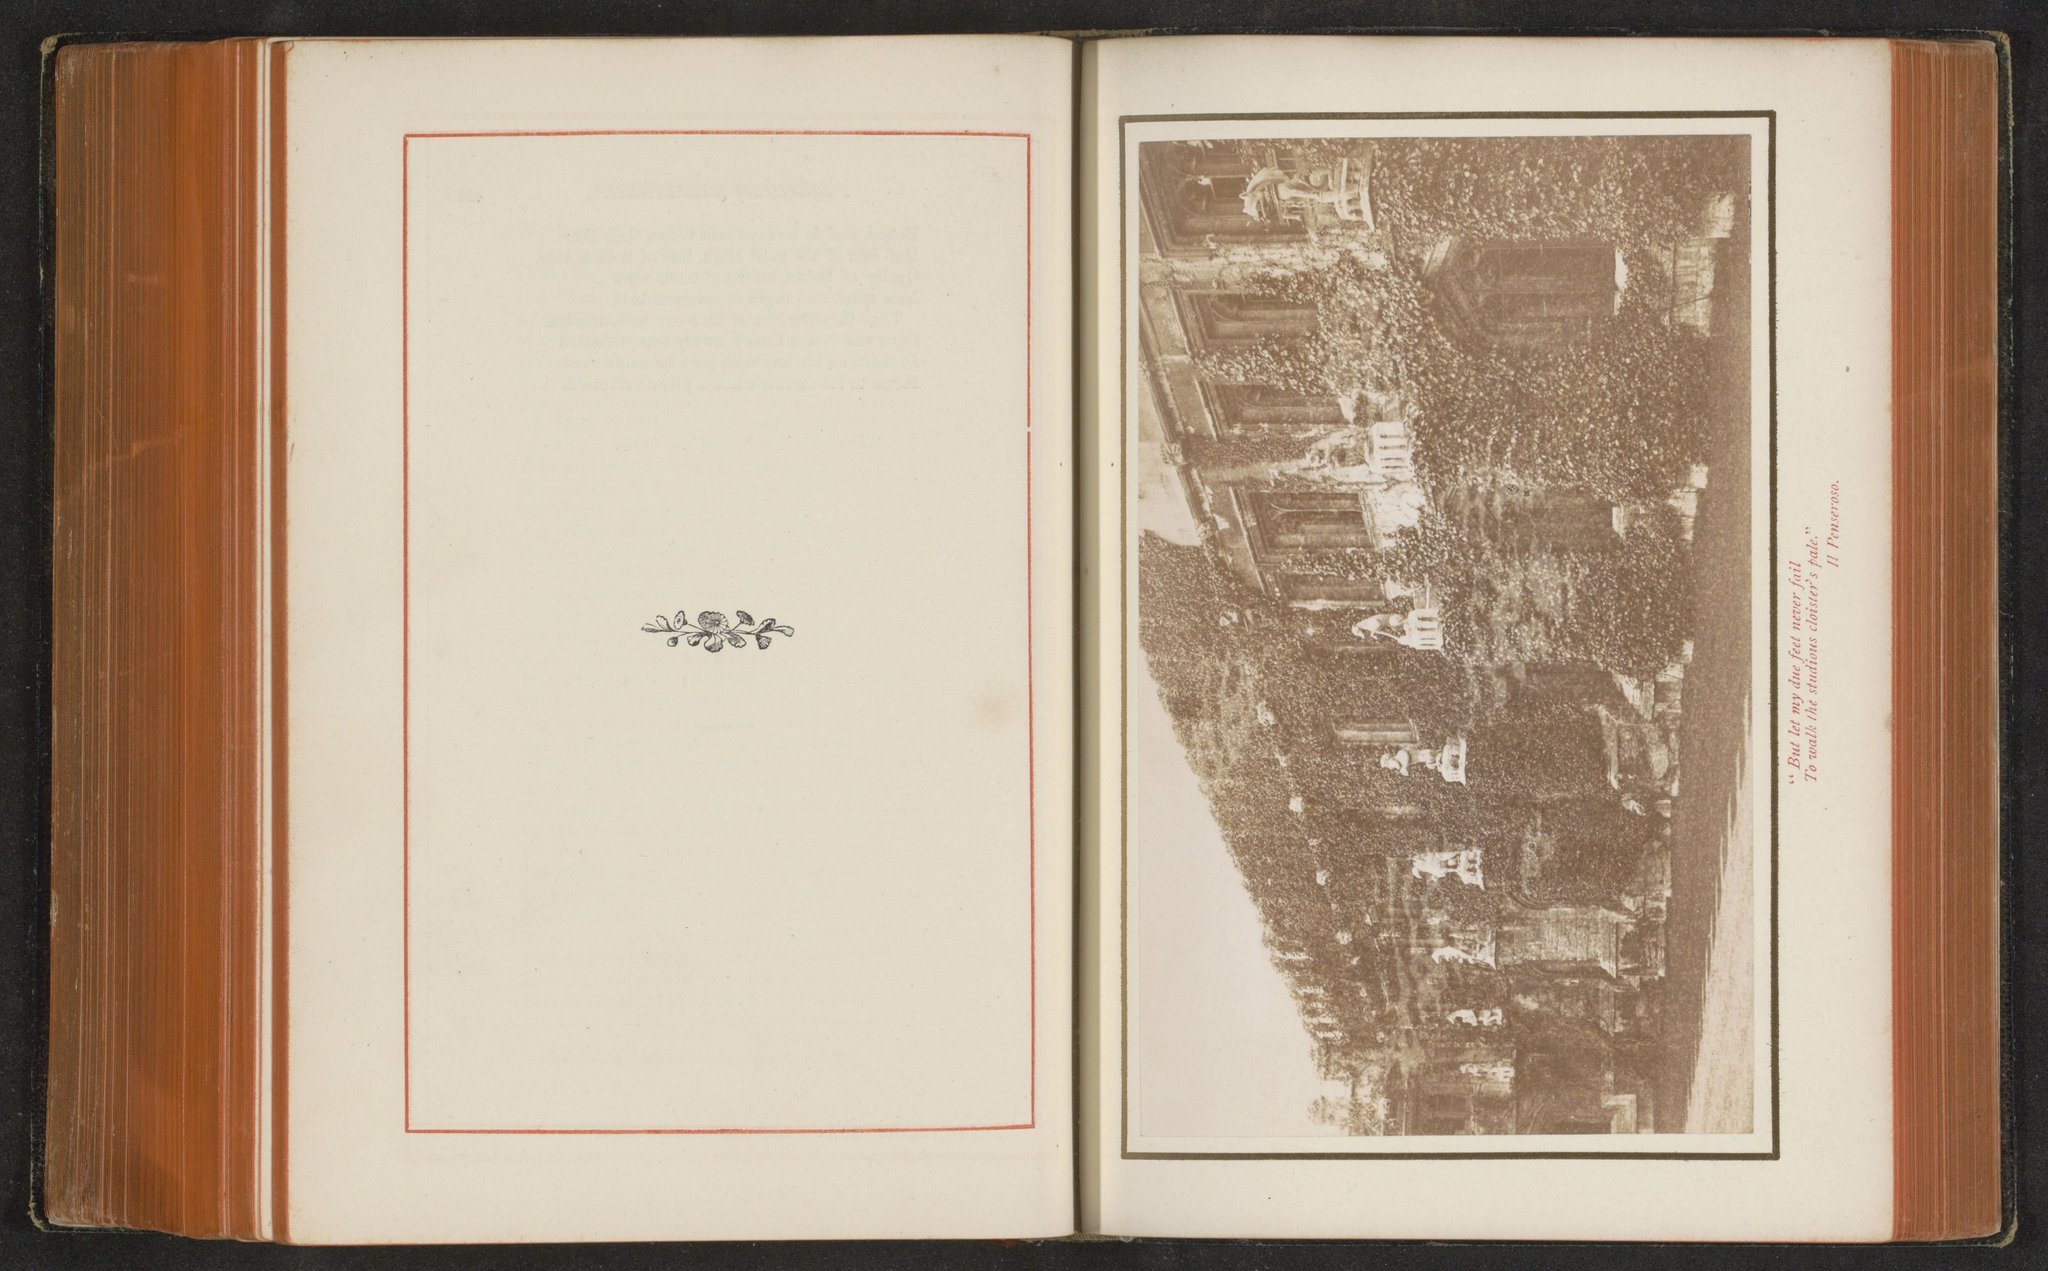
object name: photograph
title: Muur van een klooster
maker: deswall vaughan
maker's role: fotograaf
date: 1875-1885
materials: photographic support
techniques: albumen print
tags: cloisters ~ monastery, façade (of house or building)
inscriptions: inscription: ‘" But let my due feet never fail To walk the studious cloister's pale." Il Penseroso.’